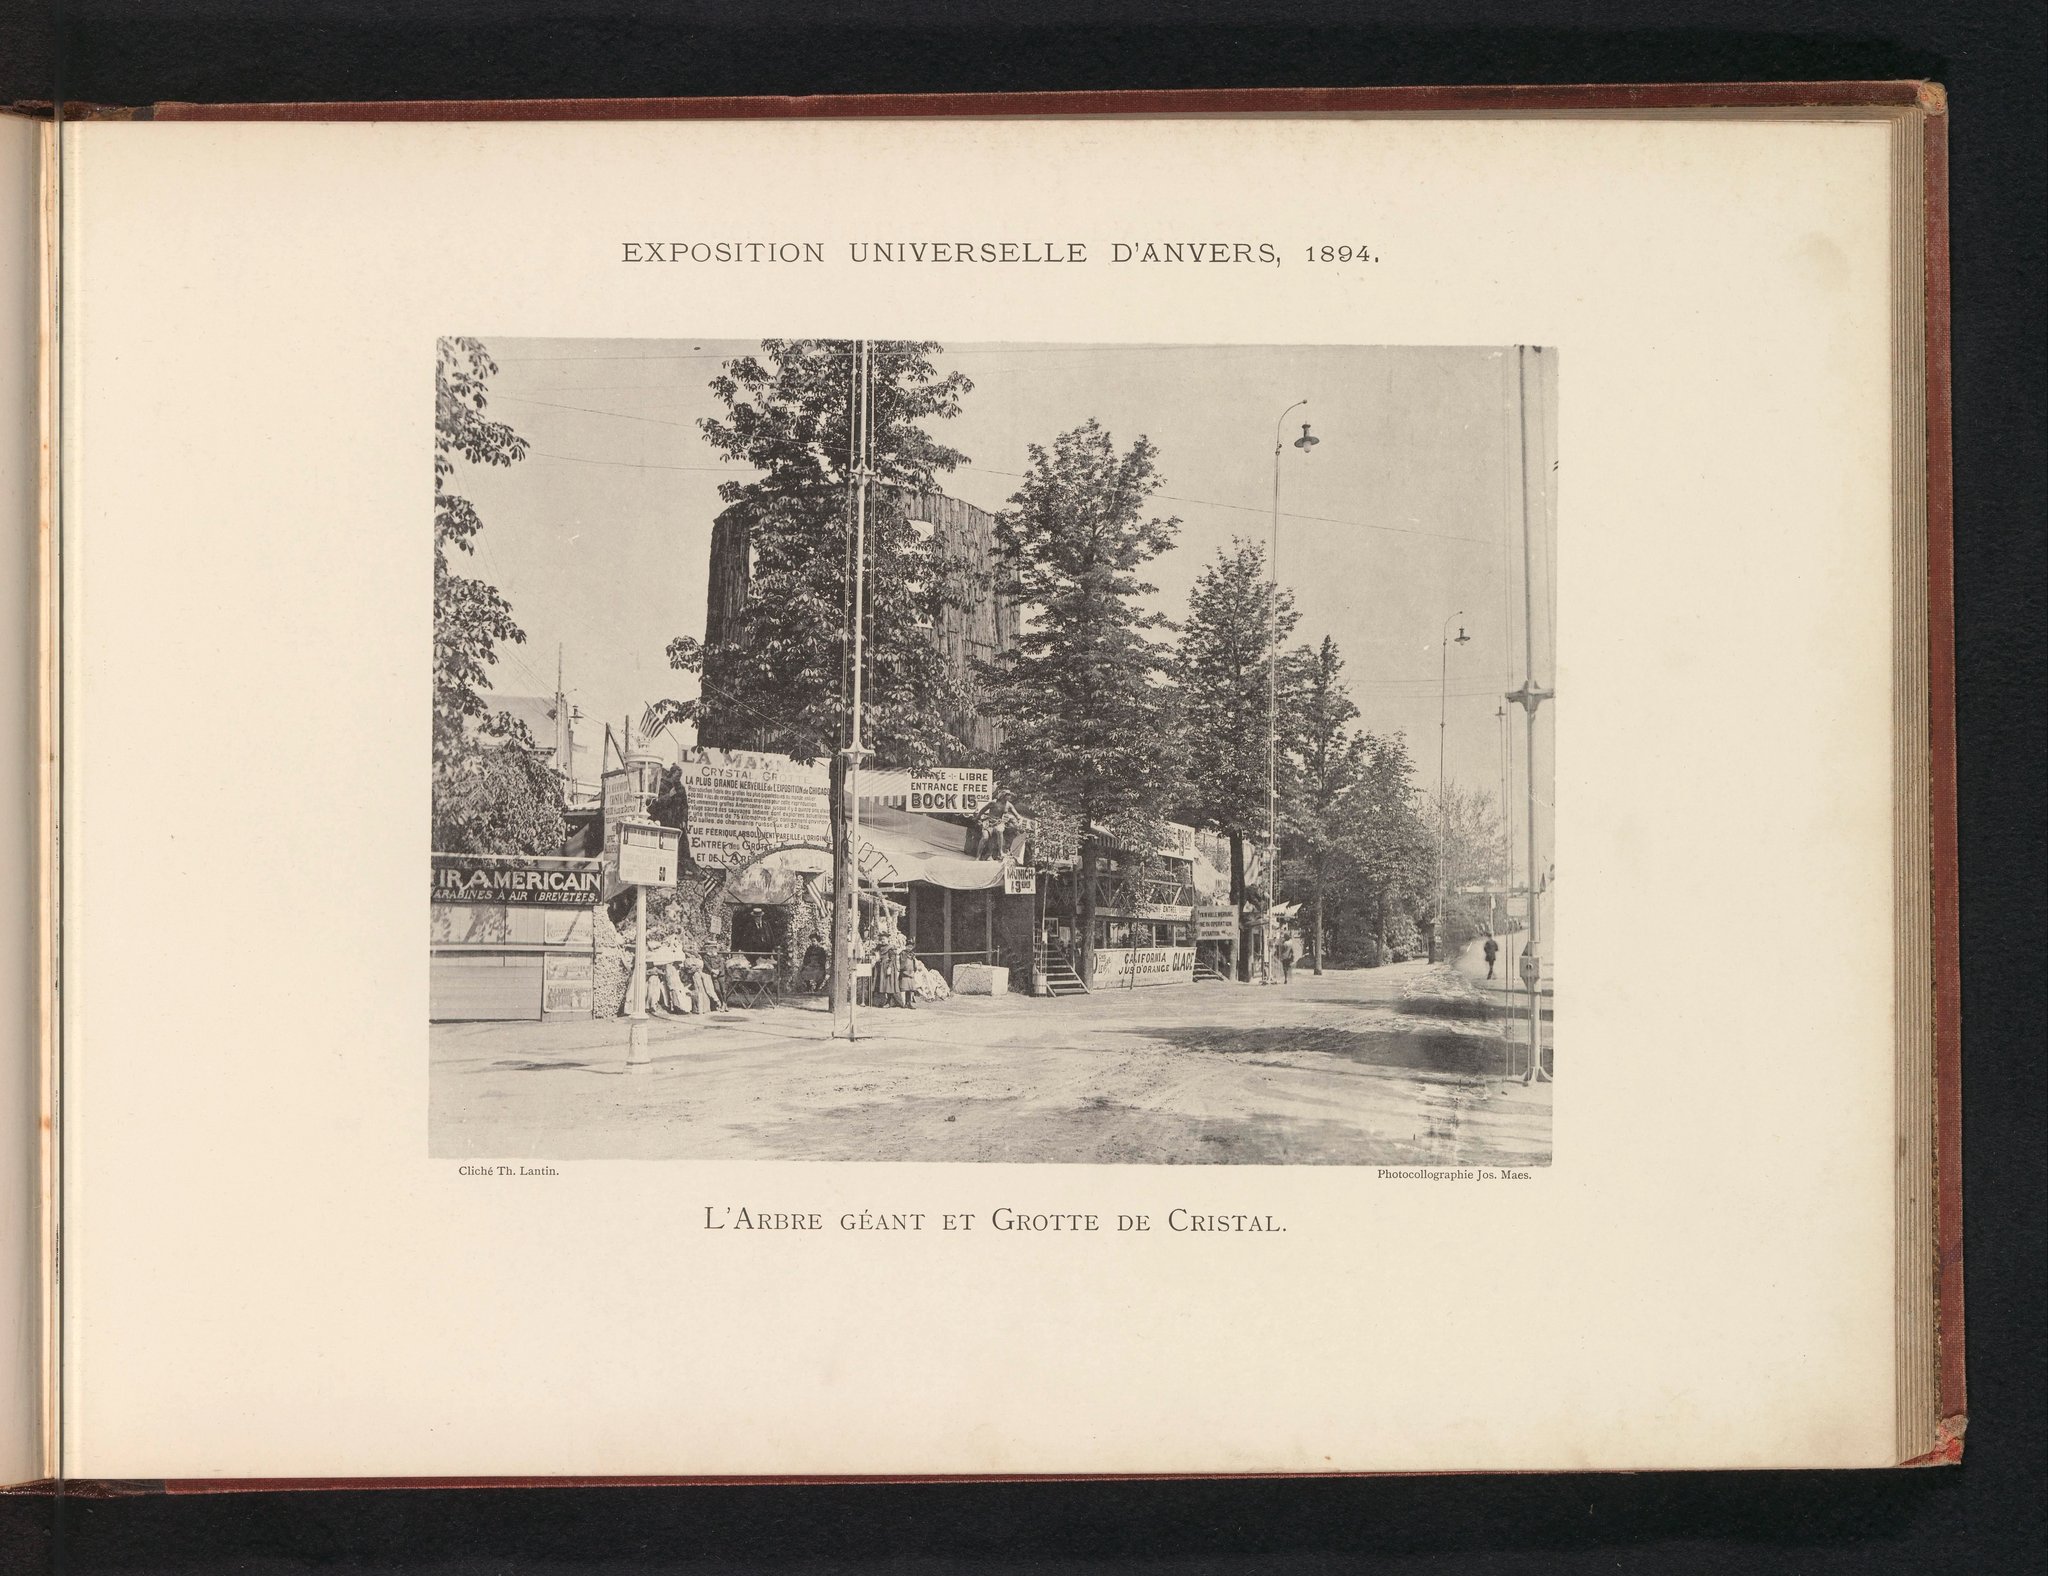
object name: photomechanical print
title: Expositie van een gigantische boom en een kristalgrot op de wereldtentoonstelling te Antwerpen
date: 1894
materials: paper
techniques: photograph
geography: antwerp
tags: trees, cave, grotto